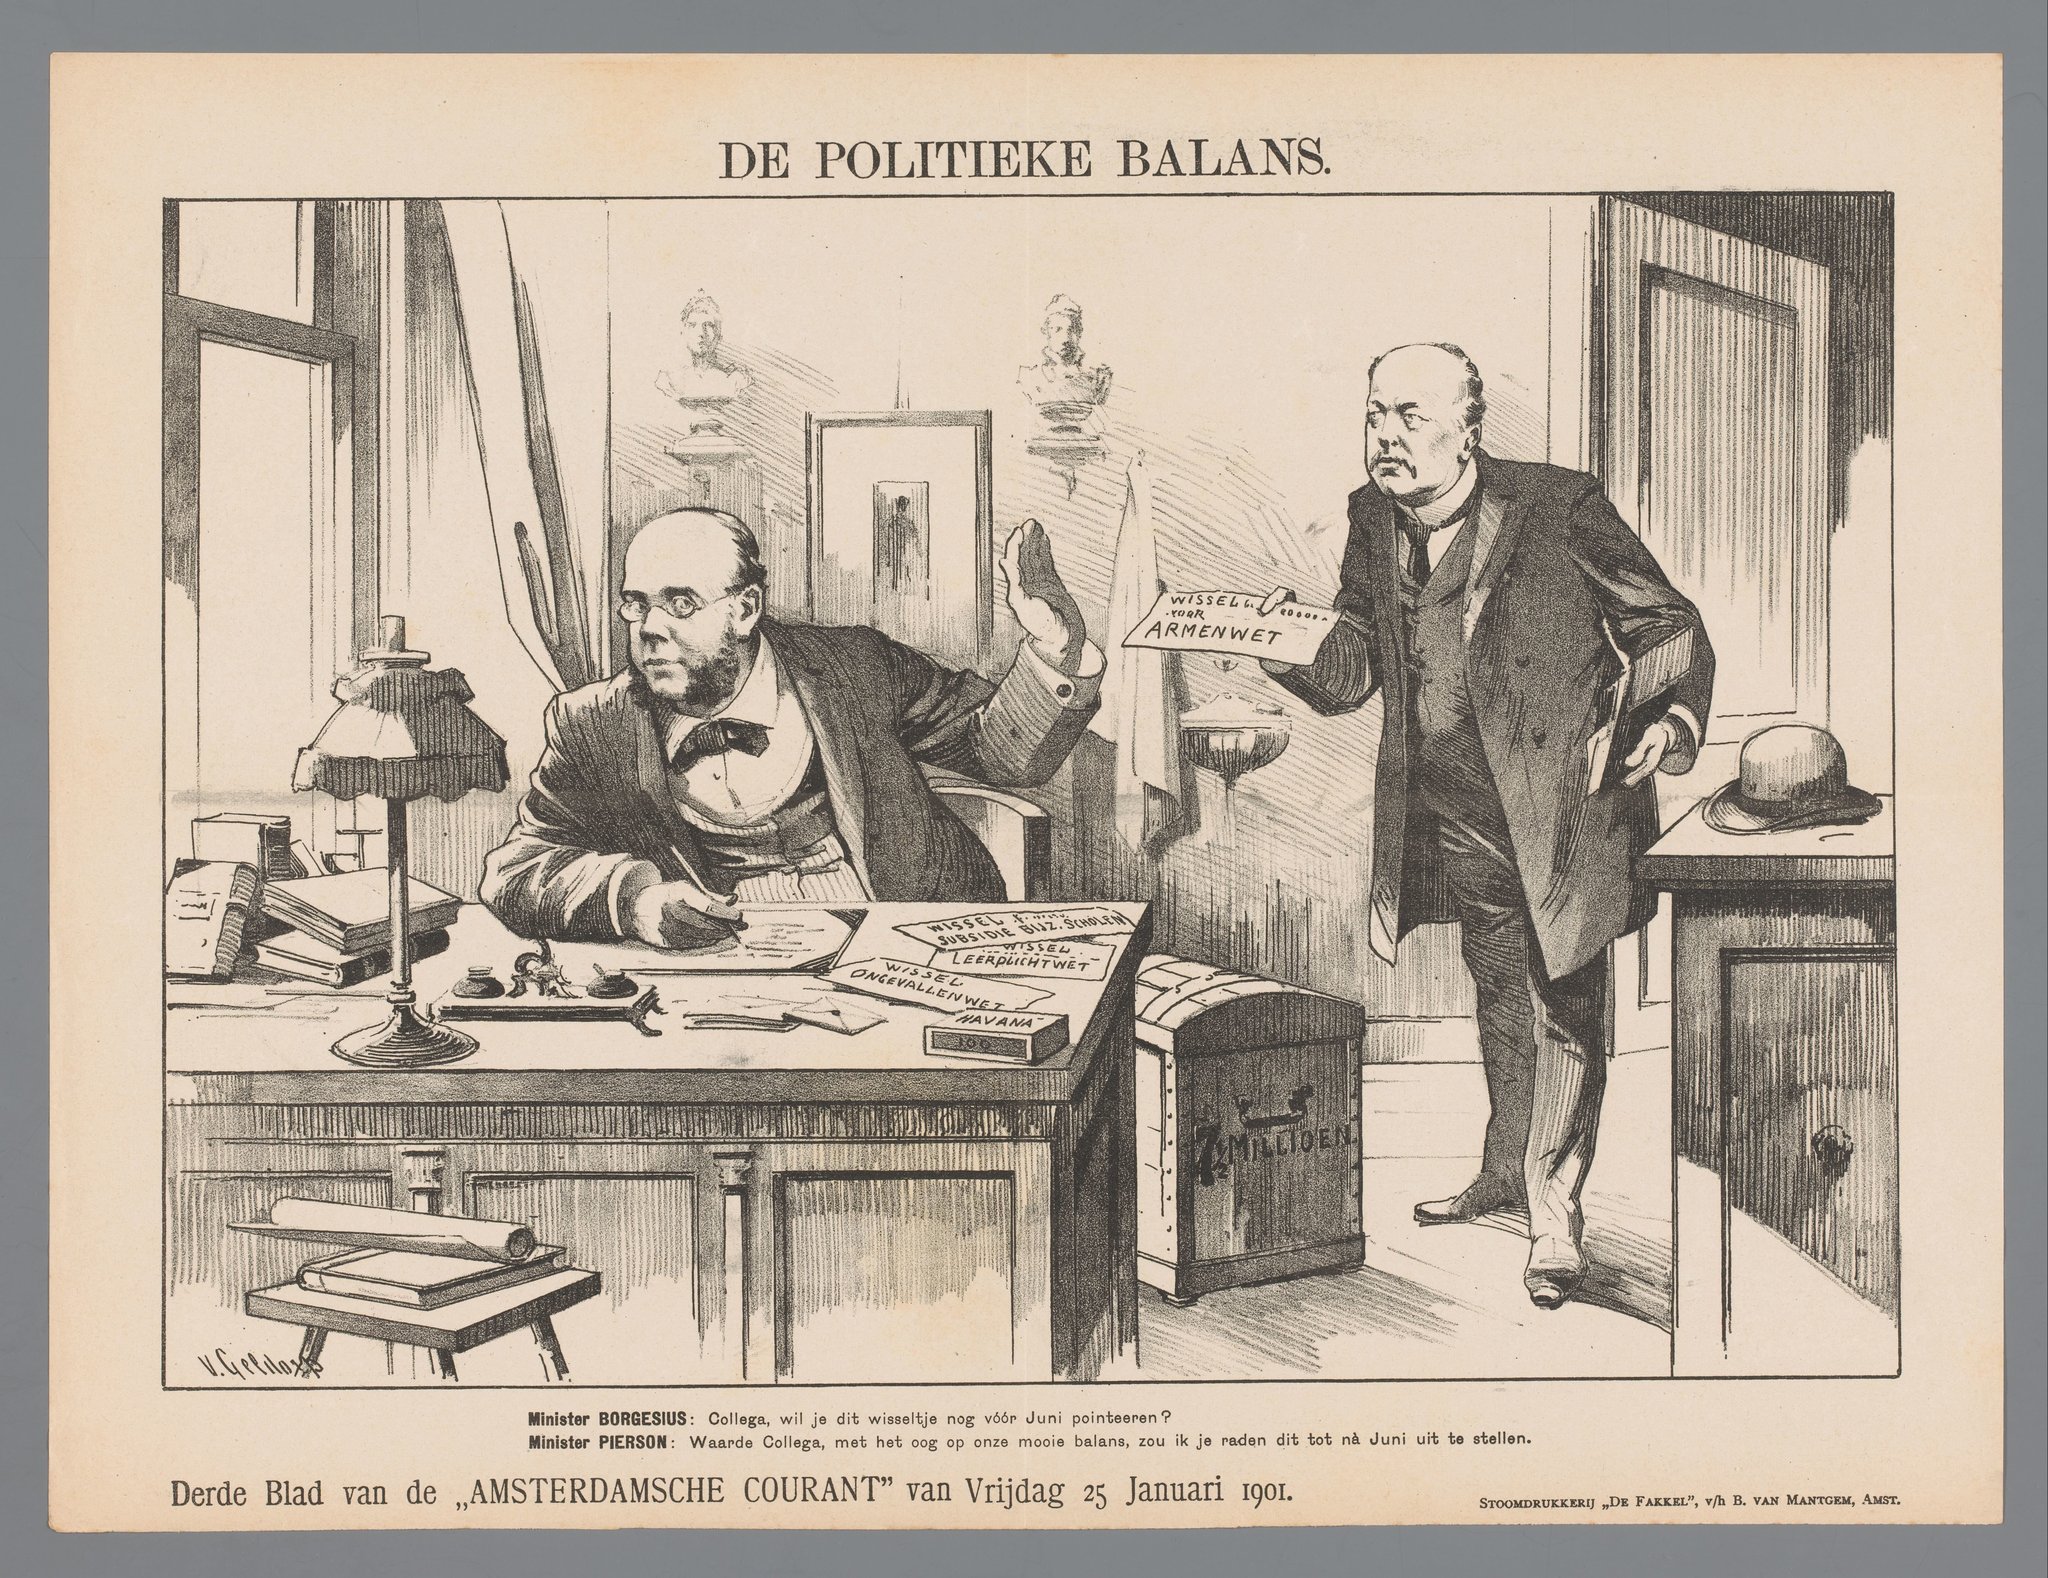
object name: cartoon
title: De politieke balans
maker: petrus van geldorp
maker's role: draughtsman, print maker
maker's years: 1872-1939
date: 1901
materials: paper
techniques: lithograph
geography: amsterdam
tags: amsterdam, politician, nicolaas gerard pierson, minister ~ government, historical persons, politician, e.g. party leader, political caricatures and satires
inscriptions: date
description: Prent uit het bijvoegsel van: De Amsterdamsche Courant, 25 januari 1901.